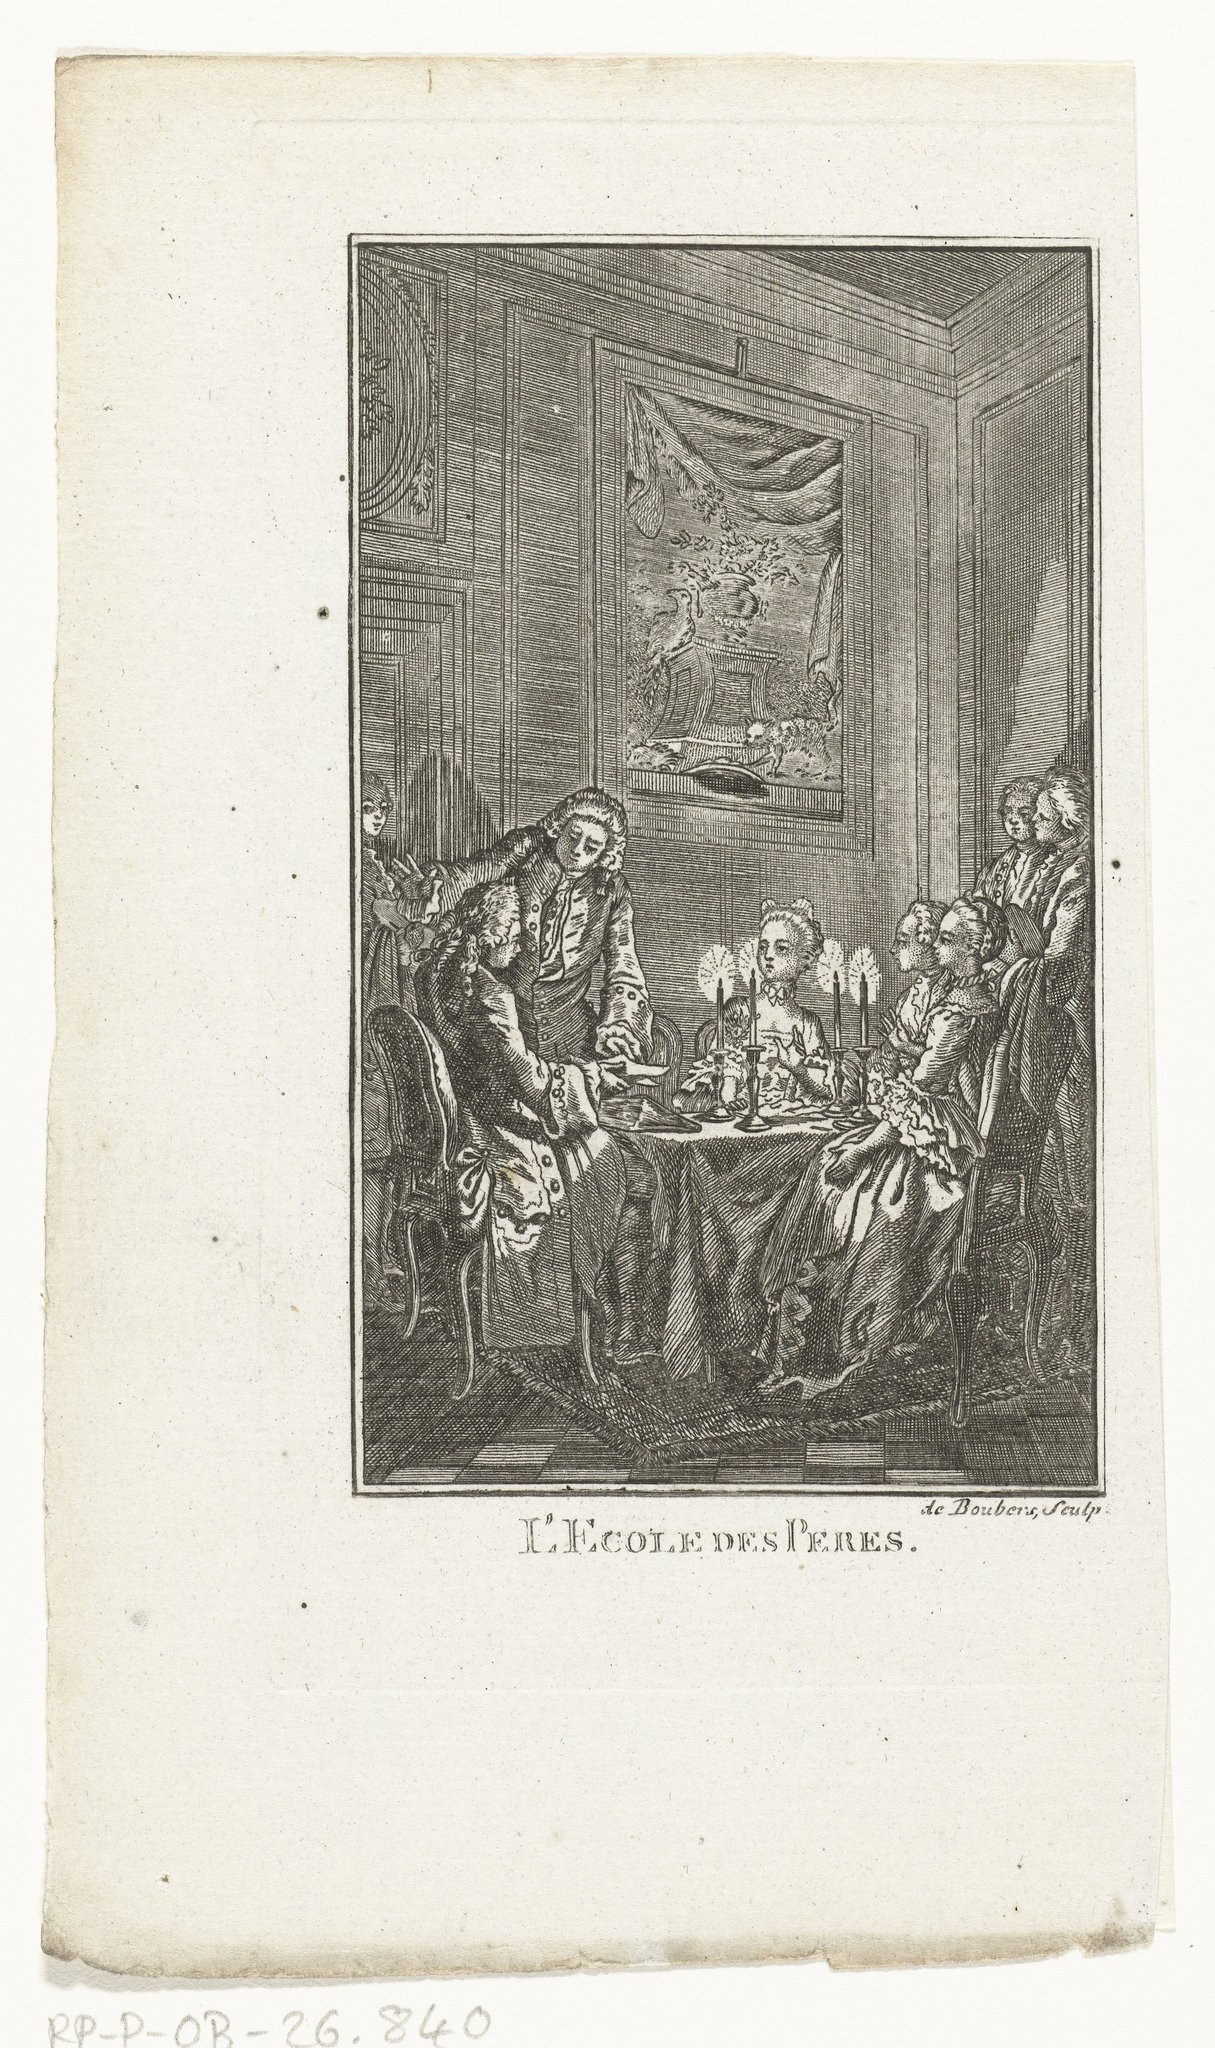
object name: print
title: L'Ecole des Peres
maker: n. de boubers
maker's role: print maker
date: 1765-1780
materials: paper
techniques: engraving, etching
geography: paris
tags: father with son(s) and daughter(s) (father-love)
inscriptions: collector's mark: Lugt 2228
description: Illustratie voor het verhaal 'L'Ecole des Peres' uit J.F. Marmontel's verhalenbundel 'Contes moreaux'. Een vader zit met zijn dochter en haar vriendinnen aan tafel. Zijn zoon komt met een vriend binnen. De vader ontvangt onder het eten een brief.